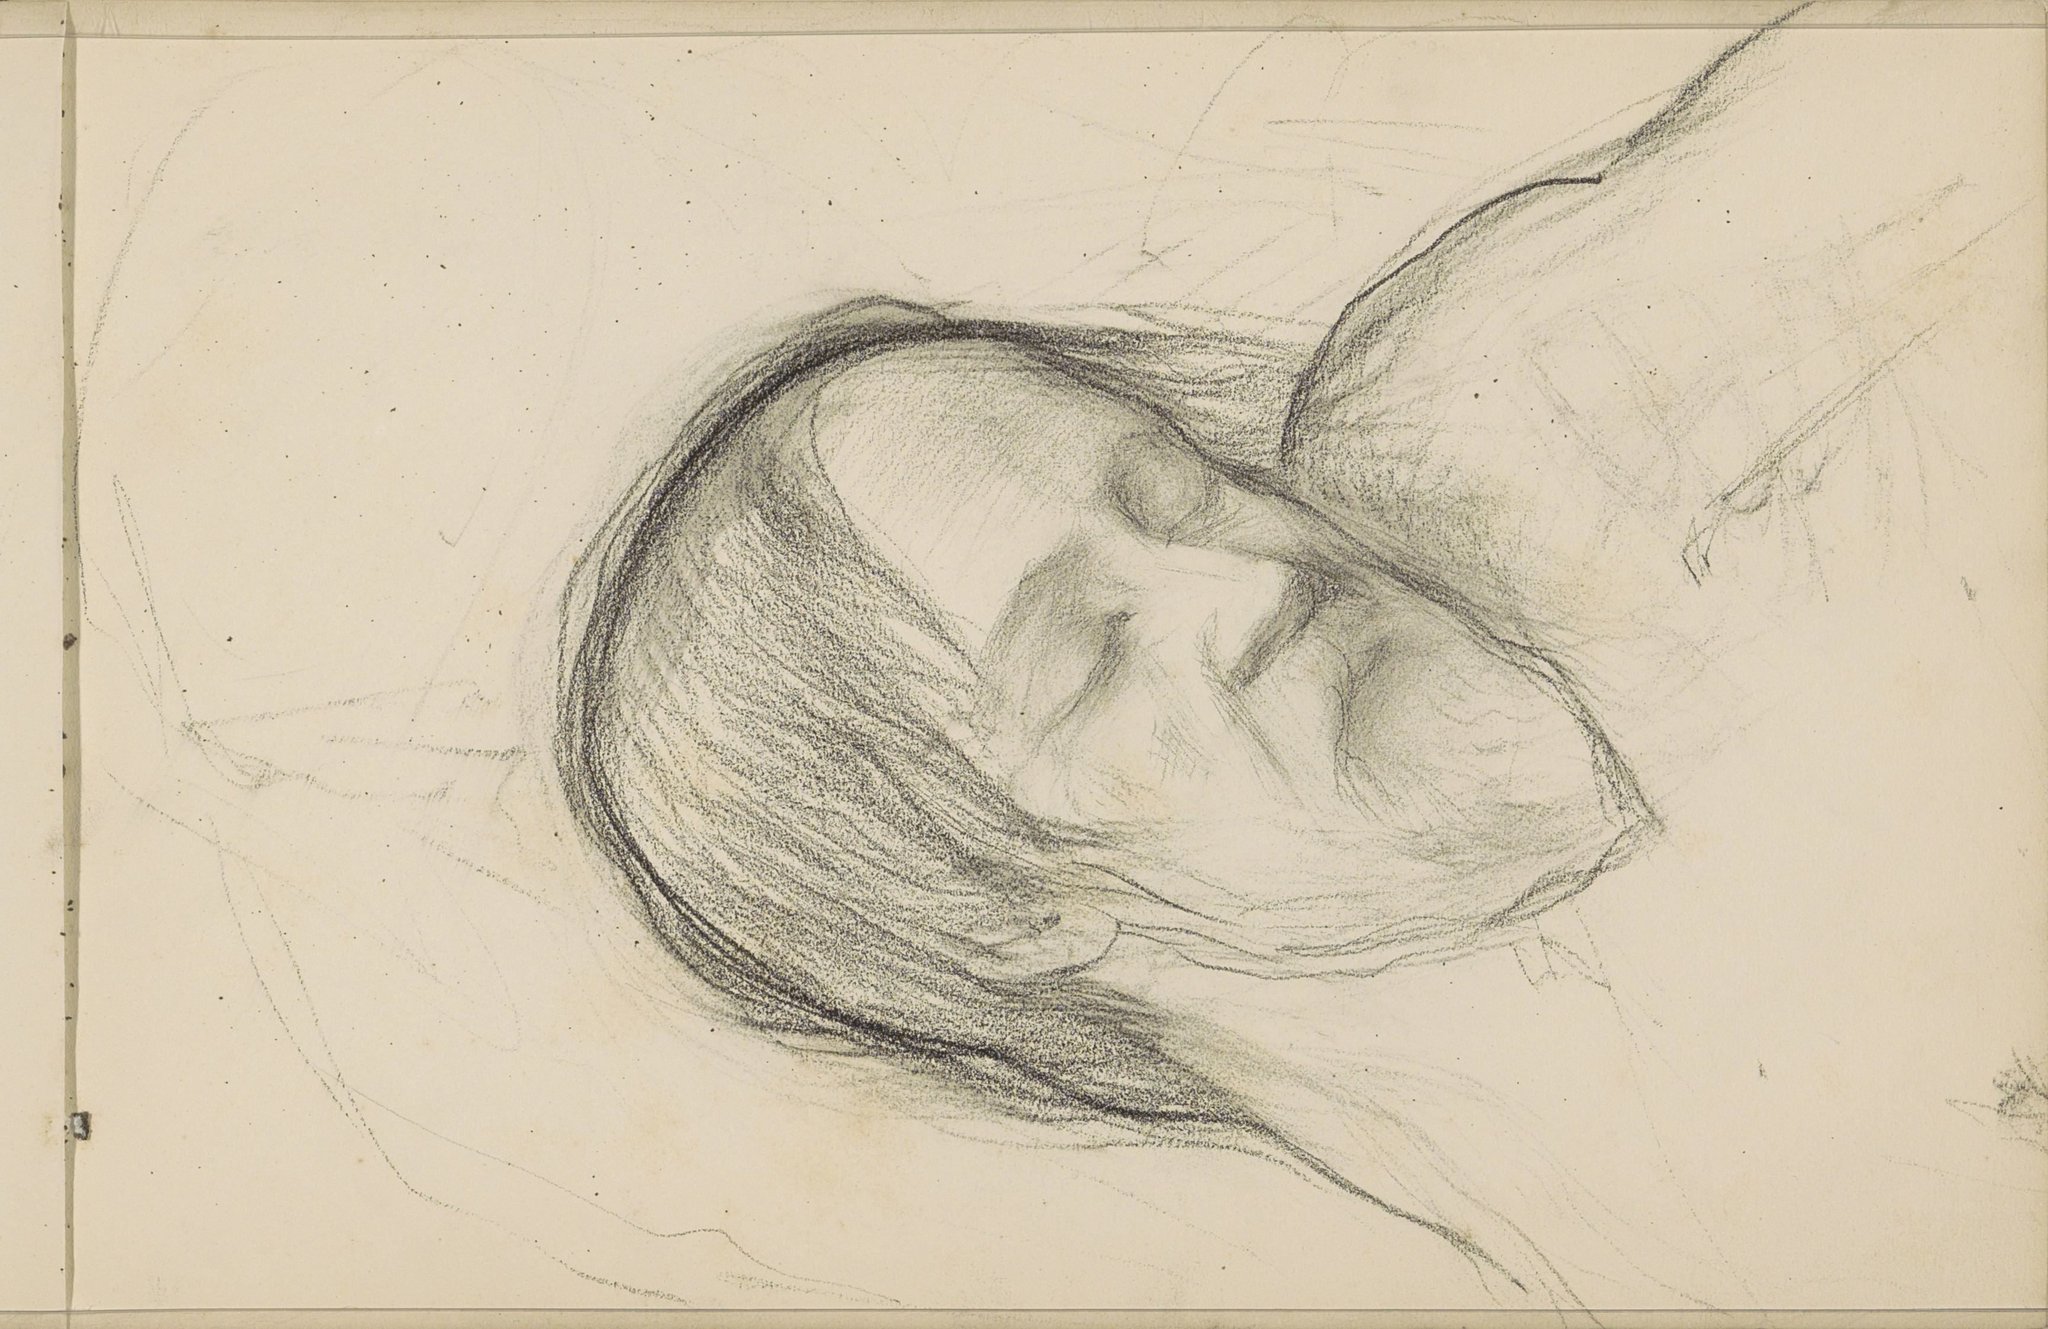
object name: sketchbook leaf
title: Kop van een man met halflang stijl haar en een baard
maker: a.a.l. de grammont-hubrecht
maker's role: draughtsman, painter, print maker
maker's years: 1855-1913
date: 1865-1913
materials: chalk, paper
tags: head (human), adult man, eyes closed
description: Het hoofd van de man rust op zijn linkerschouder en de man heeft de ogen gesloten. Blad 2 recto uit een schetsboek met 65 bladen.